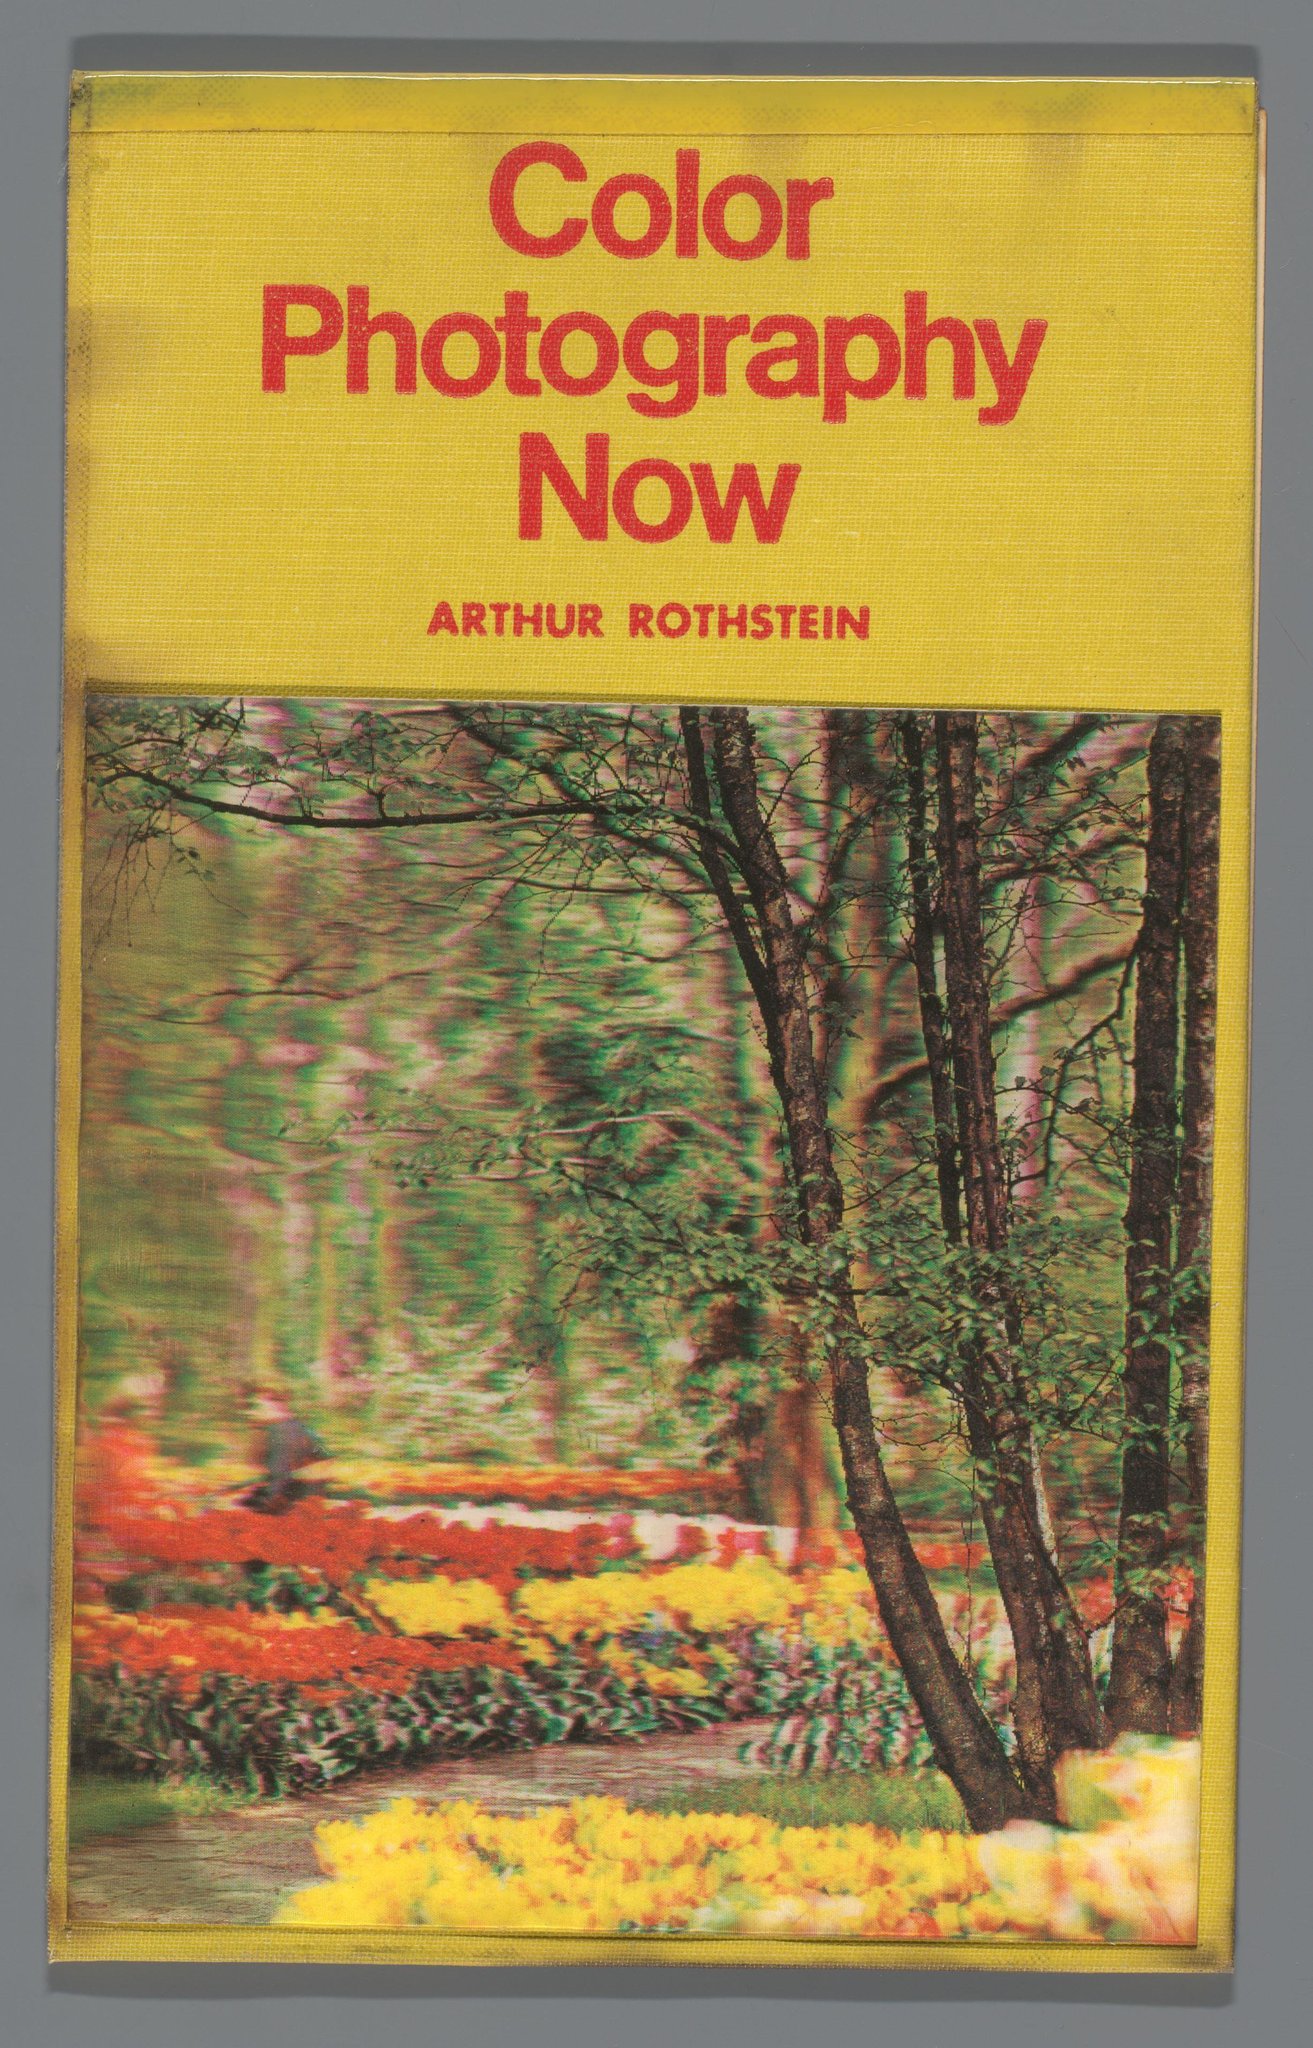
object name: photomechanical print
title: Tuin met bloeiende tulpen en bomen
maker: Anonymous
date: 1970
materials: paper, plastic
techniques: offset printed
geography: new york city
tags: trees, flowers: tulip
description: Lenticulaire druk op de kaft van Color Photography Now van Arthur Rothstein.